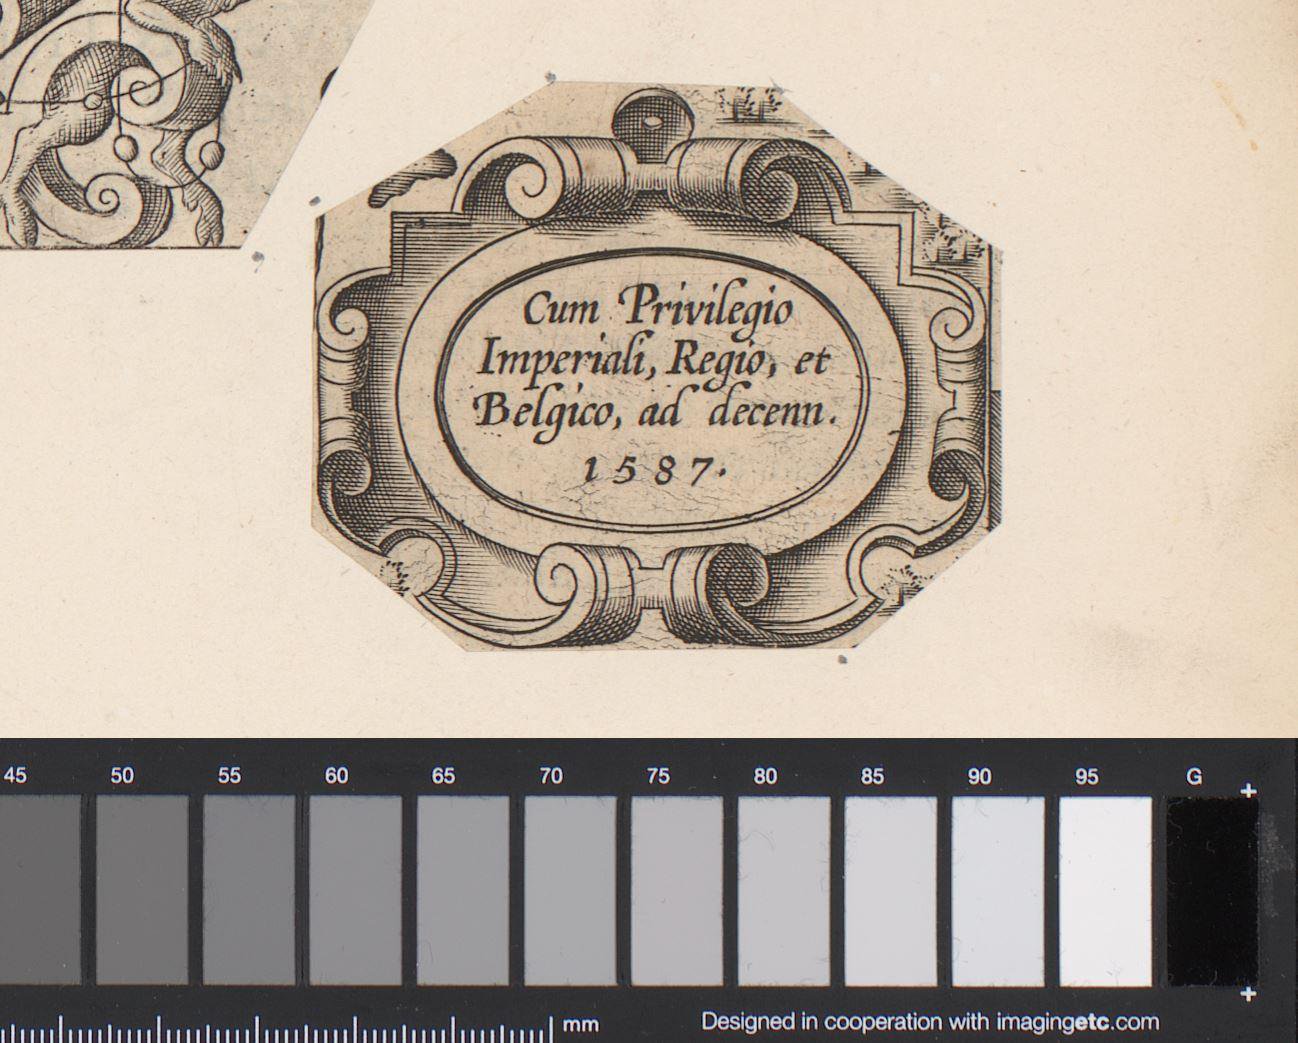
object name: album leaf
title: Germaniae Veteris Typus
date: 1587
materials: paper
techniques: engraving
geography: antwerp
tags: scrollwork, strapwork ~ ornament, ornament ~ cartouche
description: Ovale cartouche met rolwerk. De cartouche is een fragment van een kaart van Duitsland. De prent maakt deel uit van een album.